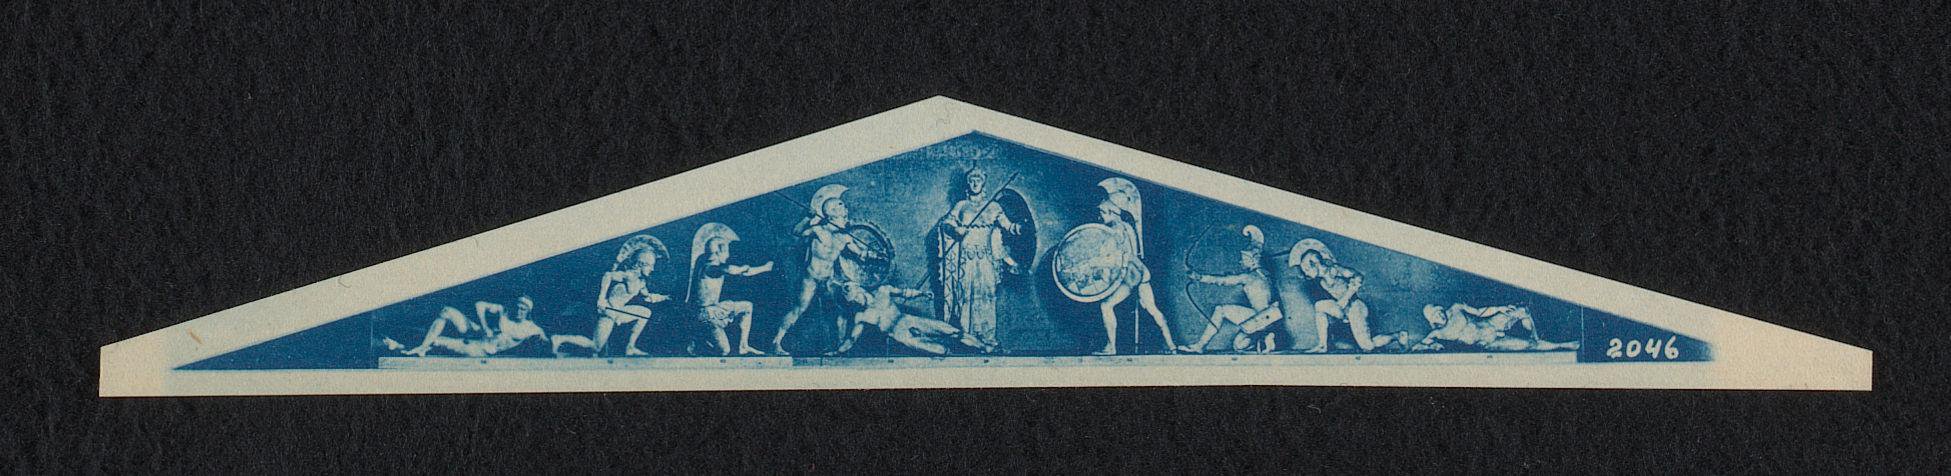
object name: reproduction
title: Fotoreproductie van een prent van een timpaan van de tempel van Aegina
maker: Anonymous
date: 1901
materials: paper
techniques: cyanotype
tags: temple, shrine ~ greek religion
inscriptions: number: ‘2046’